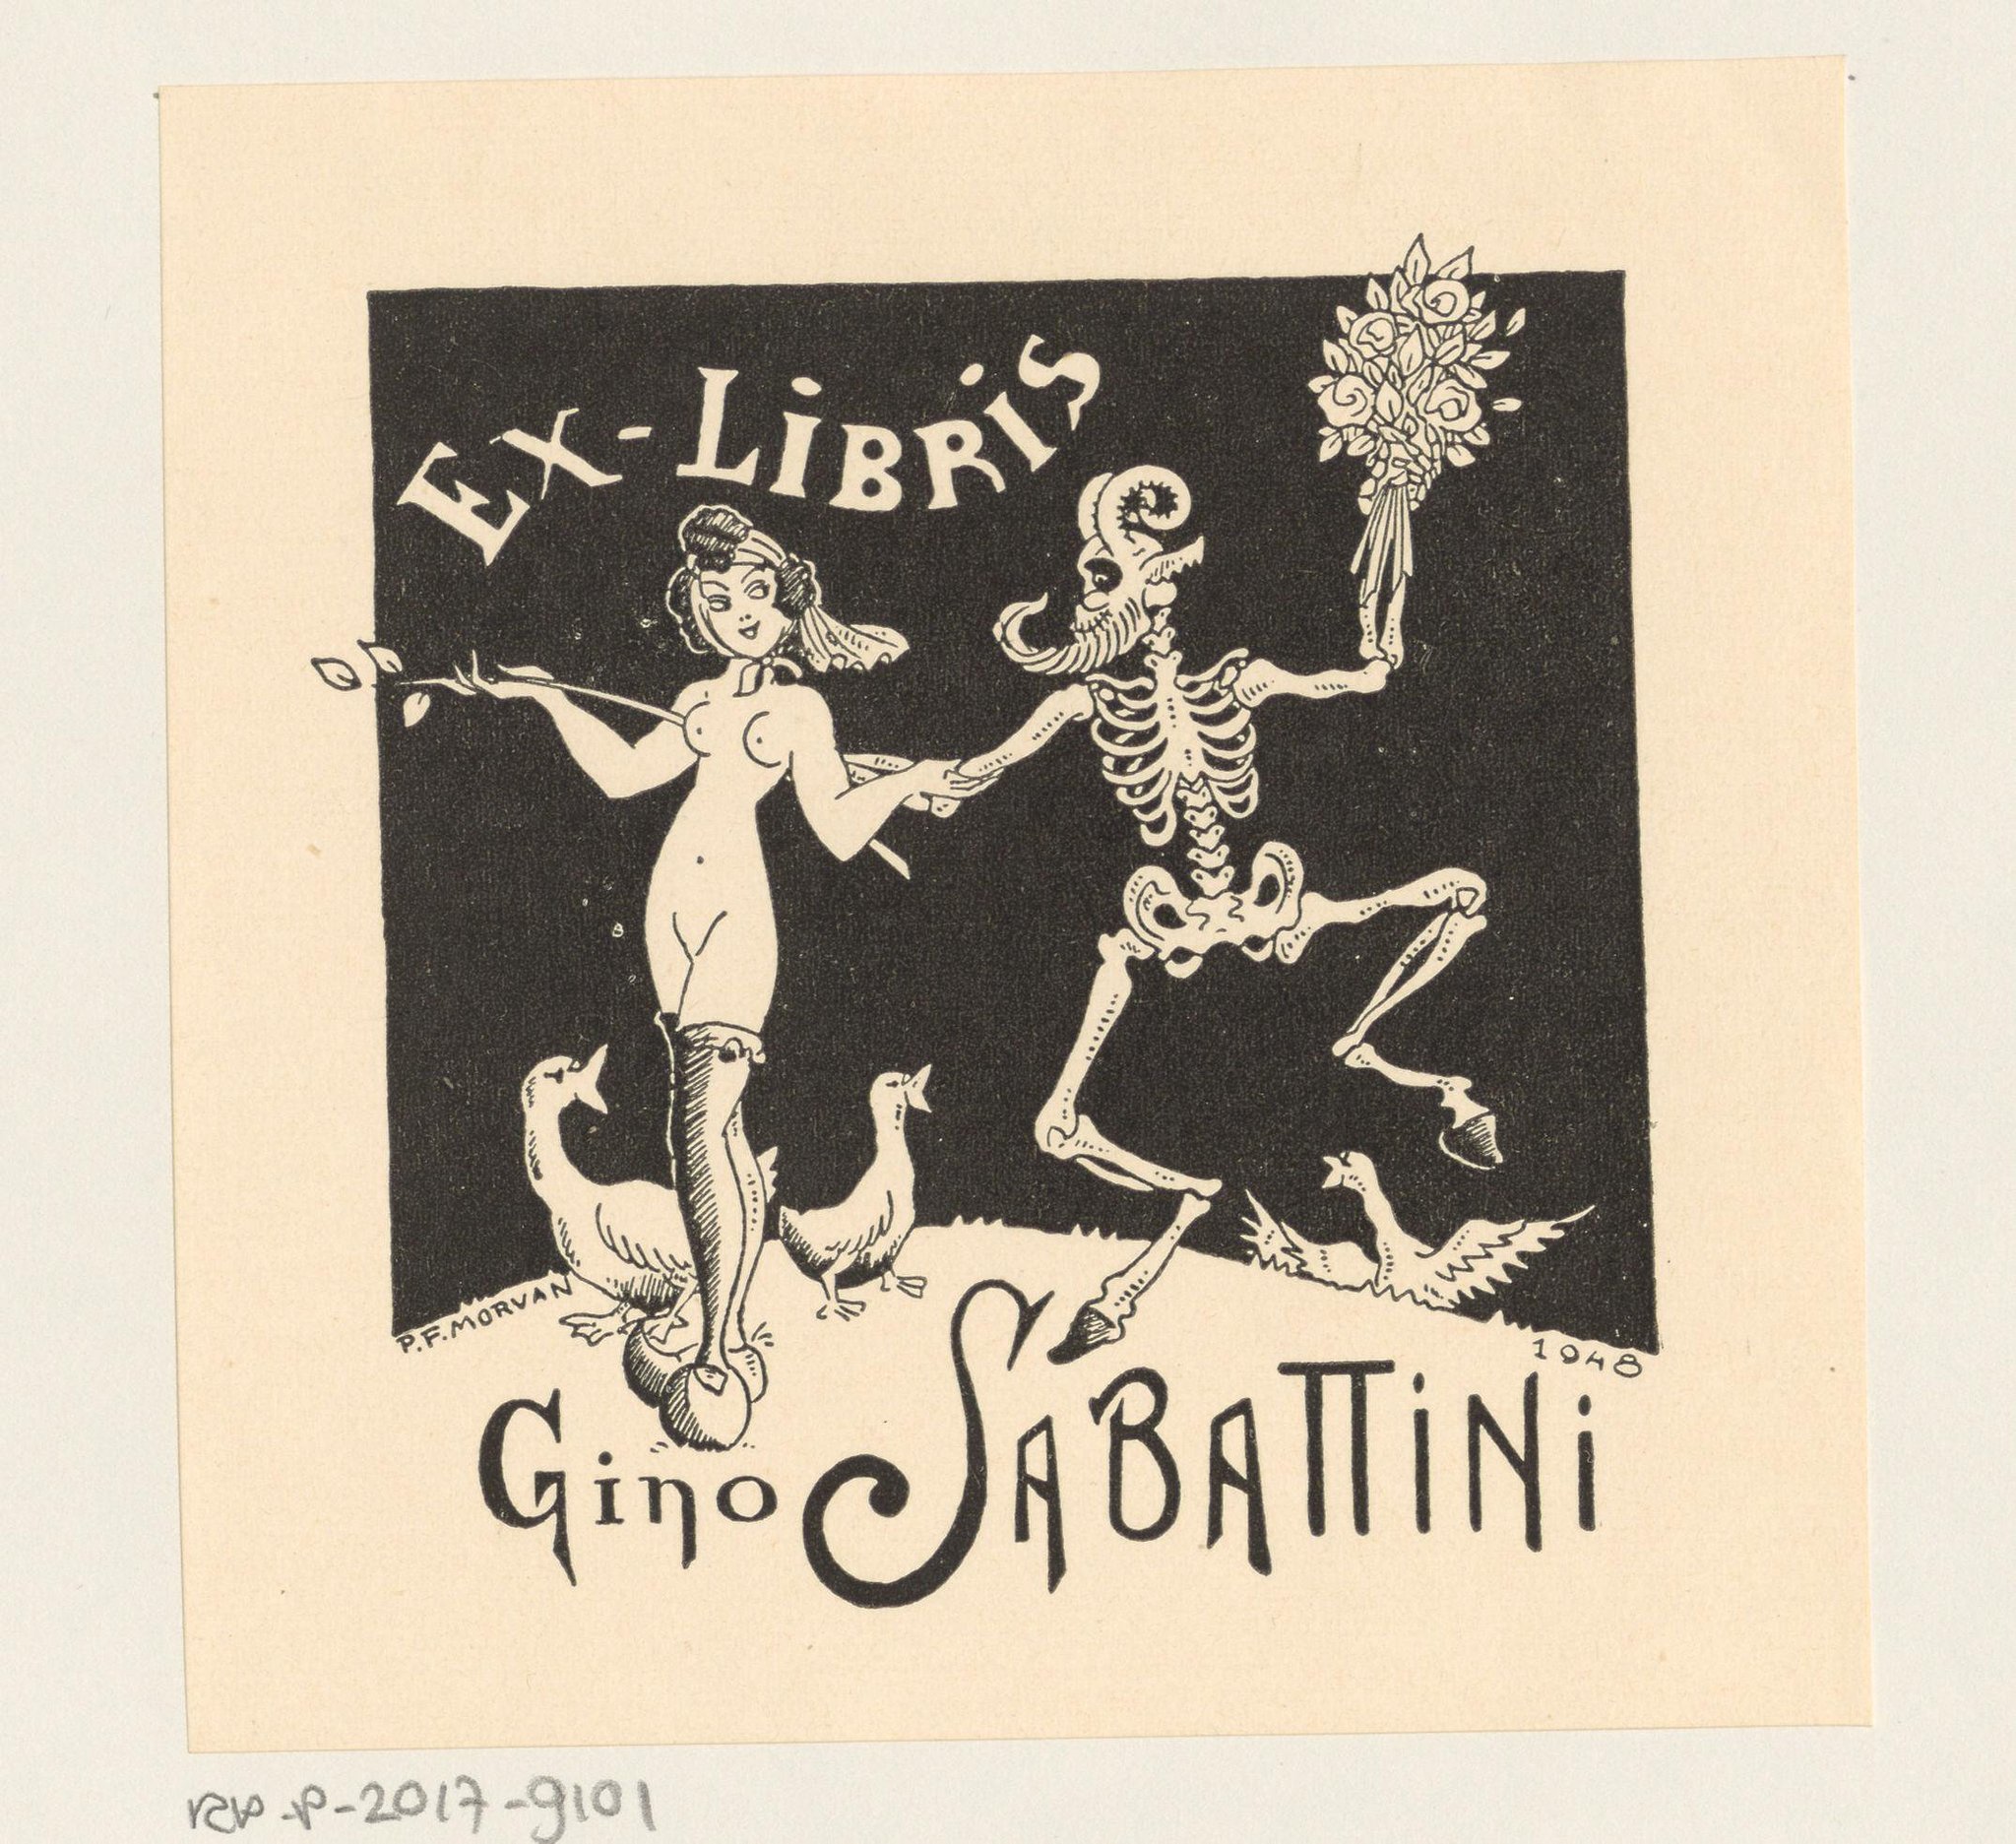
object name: bookplate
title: Ex libris van Gino Sabattini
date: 1948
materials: paper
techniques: printing block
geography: france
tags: gino sabattini, flowers, water-birds: goose, woman (showing herself) undressed, quasi-nude, (human) skeleton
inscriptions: date